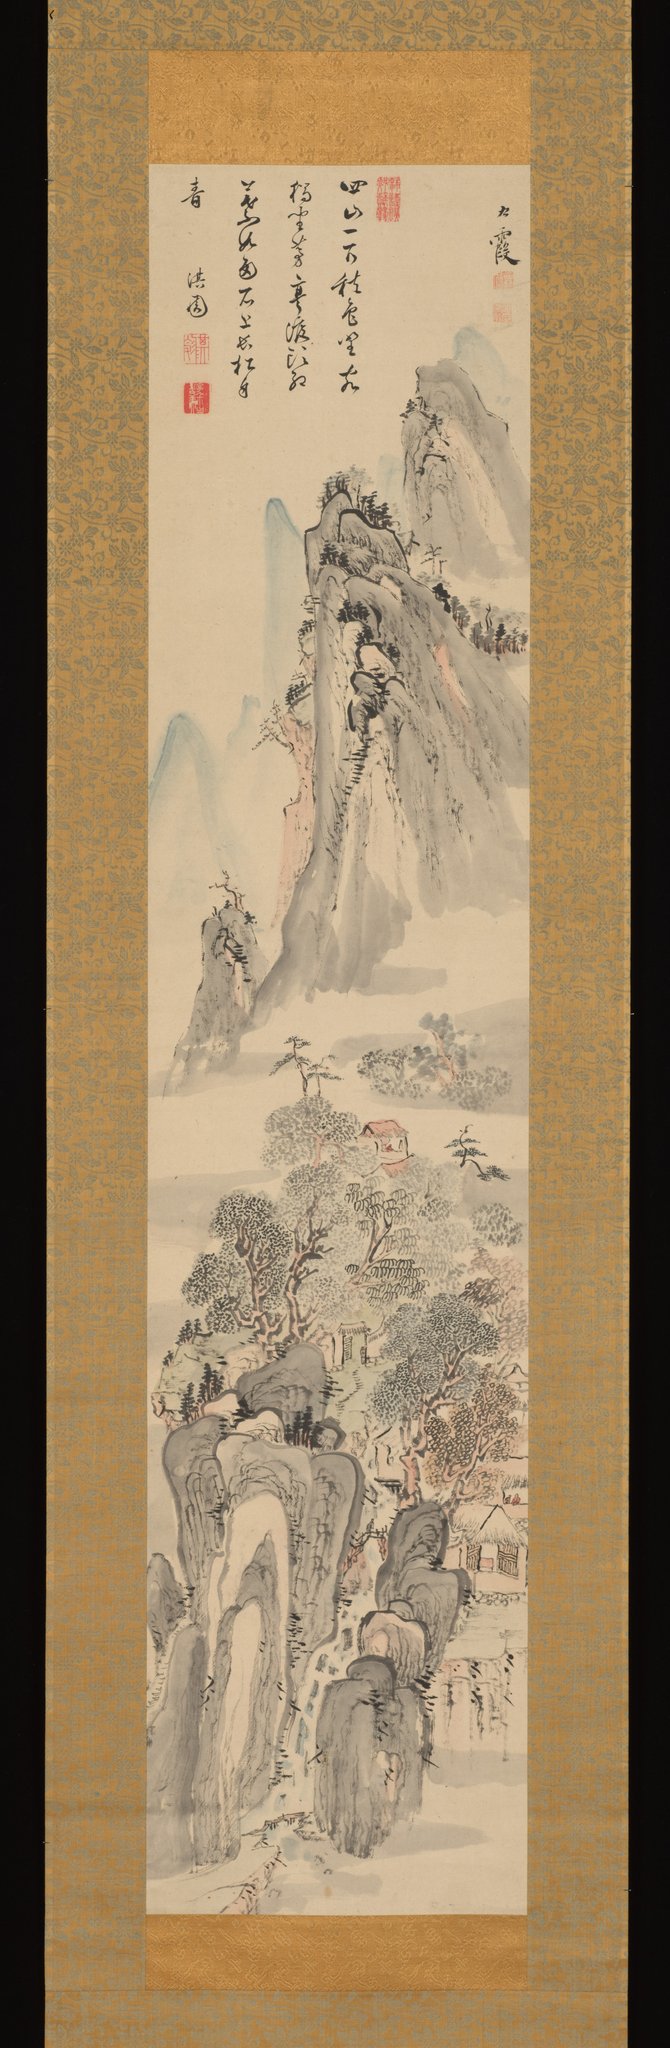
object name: hanging scroll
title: Autumn Landscape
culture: japanese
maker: ike no taiga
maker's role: artist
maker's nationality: japanese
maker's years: 1723-1776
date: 1750-1758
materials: ink, paper